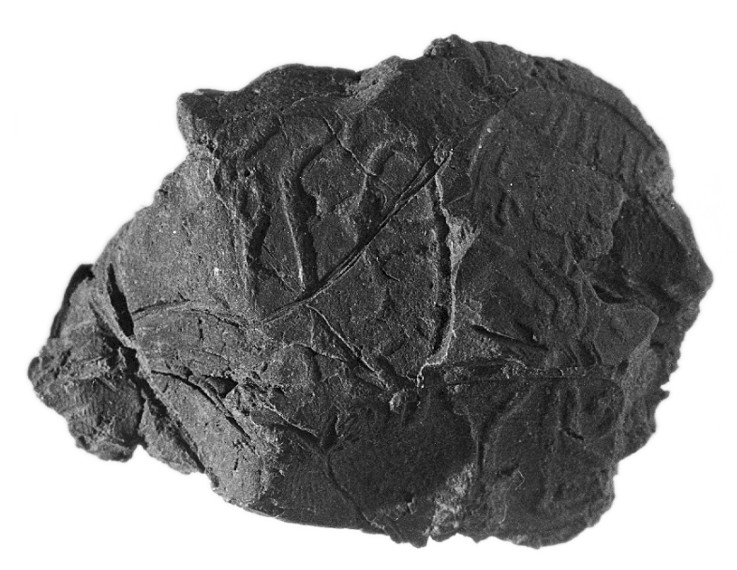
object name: sealing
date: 2030-1640 BCE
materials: clay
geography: egypt